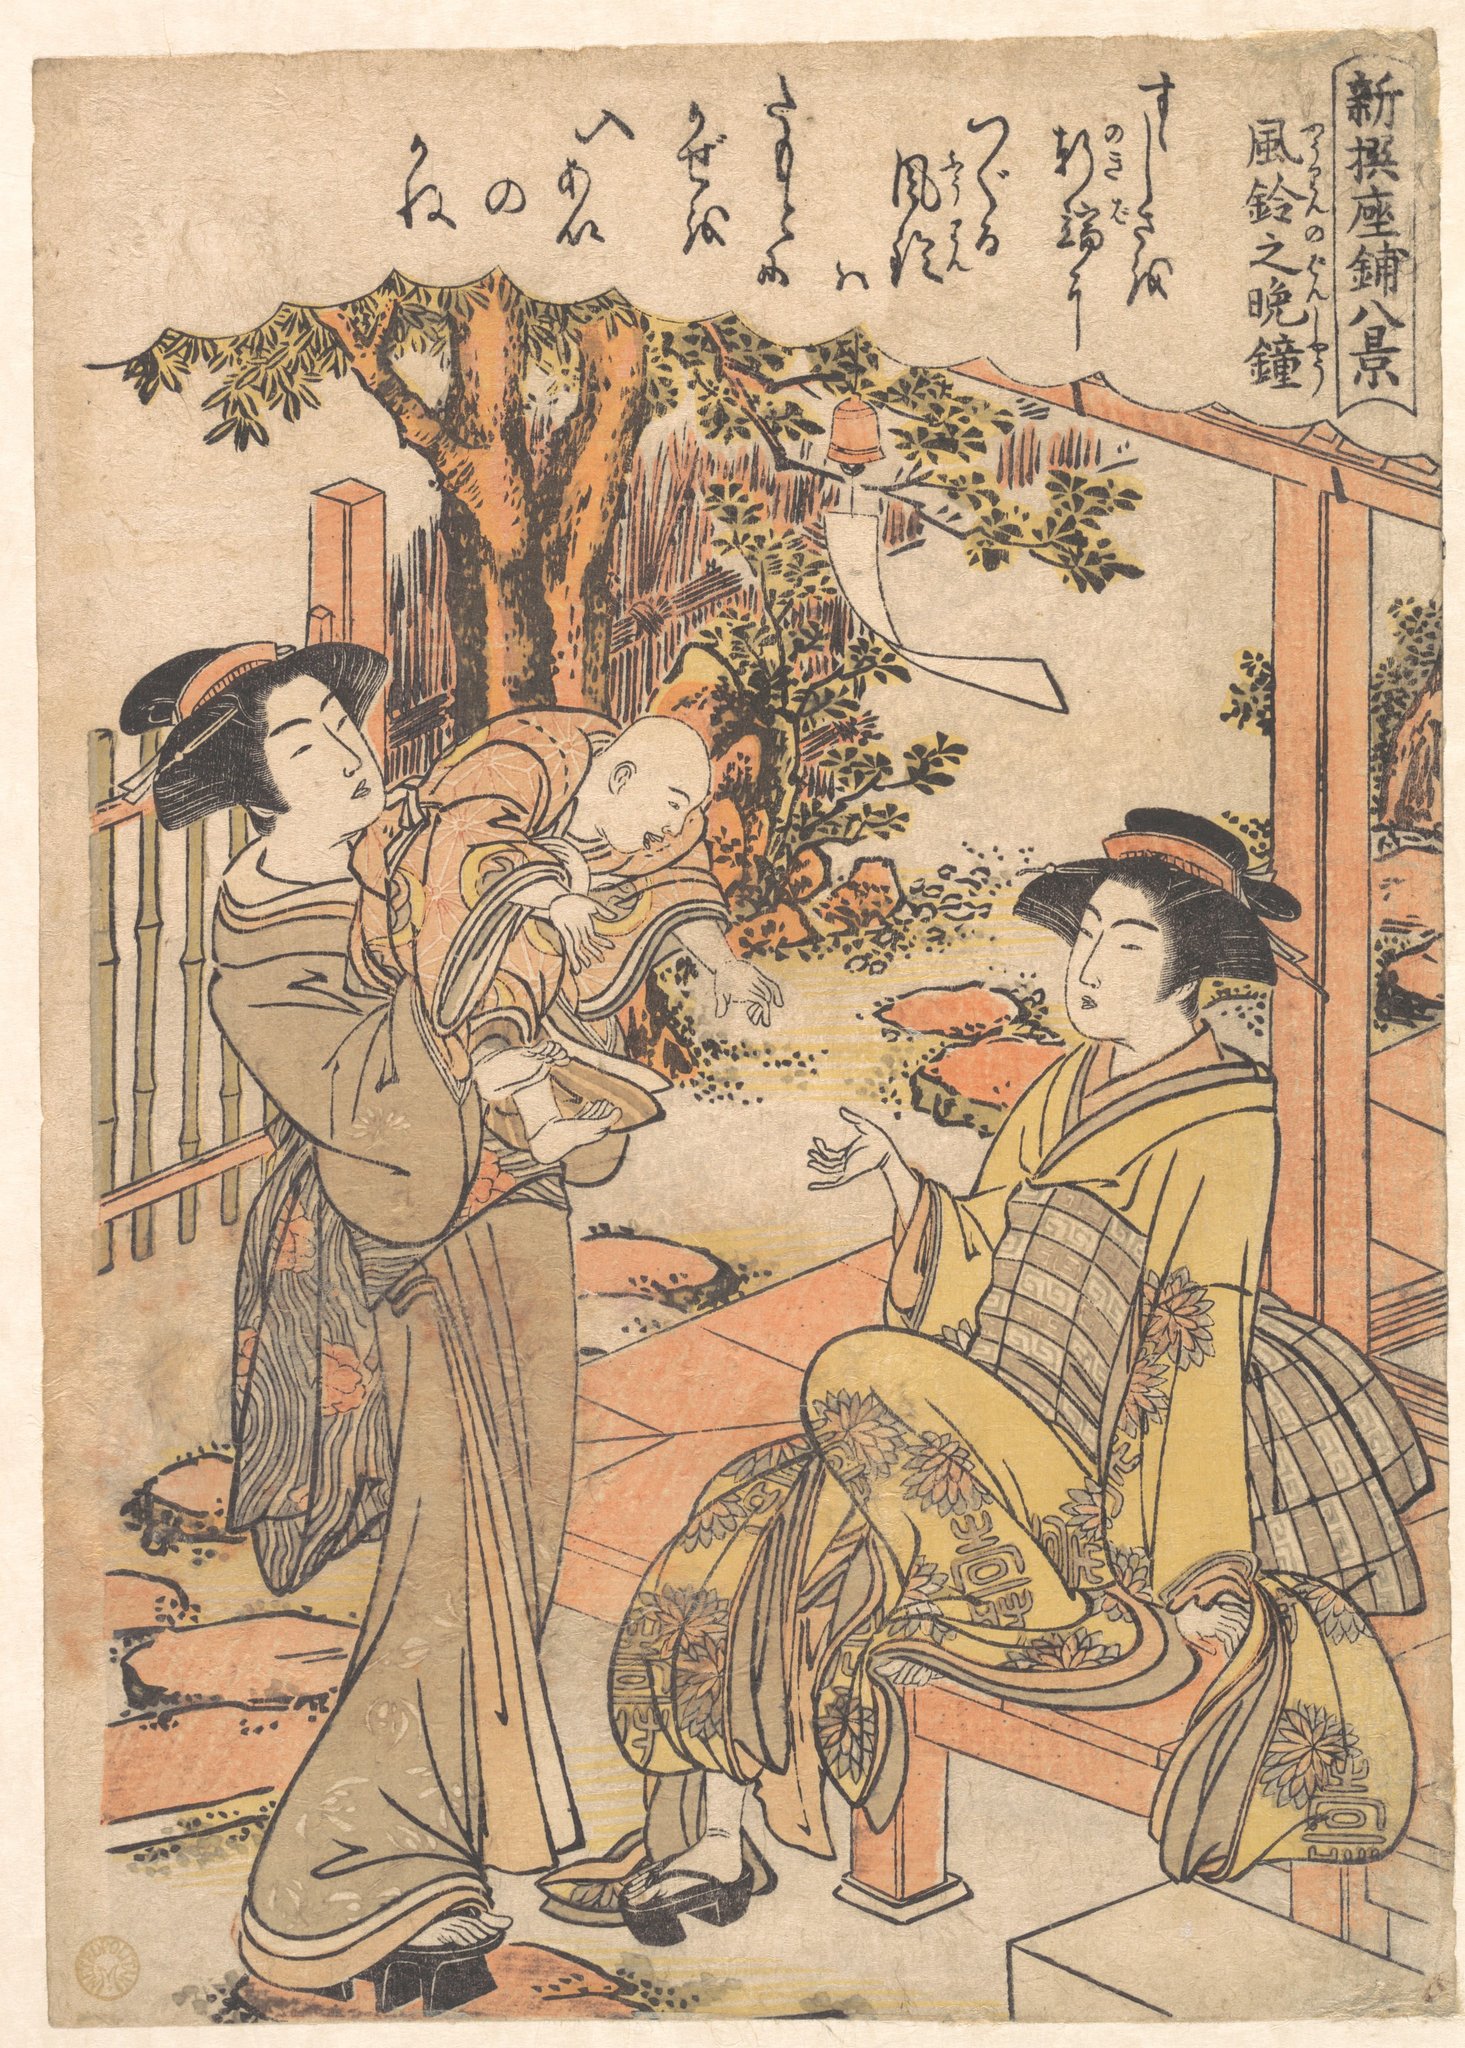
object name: woodblock print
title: The Evening Wind-bell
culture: japanese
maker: kitao masanobu (santō kyōden)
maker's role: artist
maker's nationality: japanese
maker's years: 1761-1816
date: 1783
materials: ink, paper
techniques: woodblock print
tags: musical instruments,children,women,trees